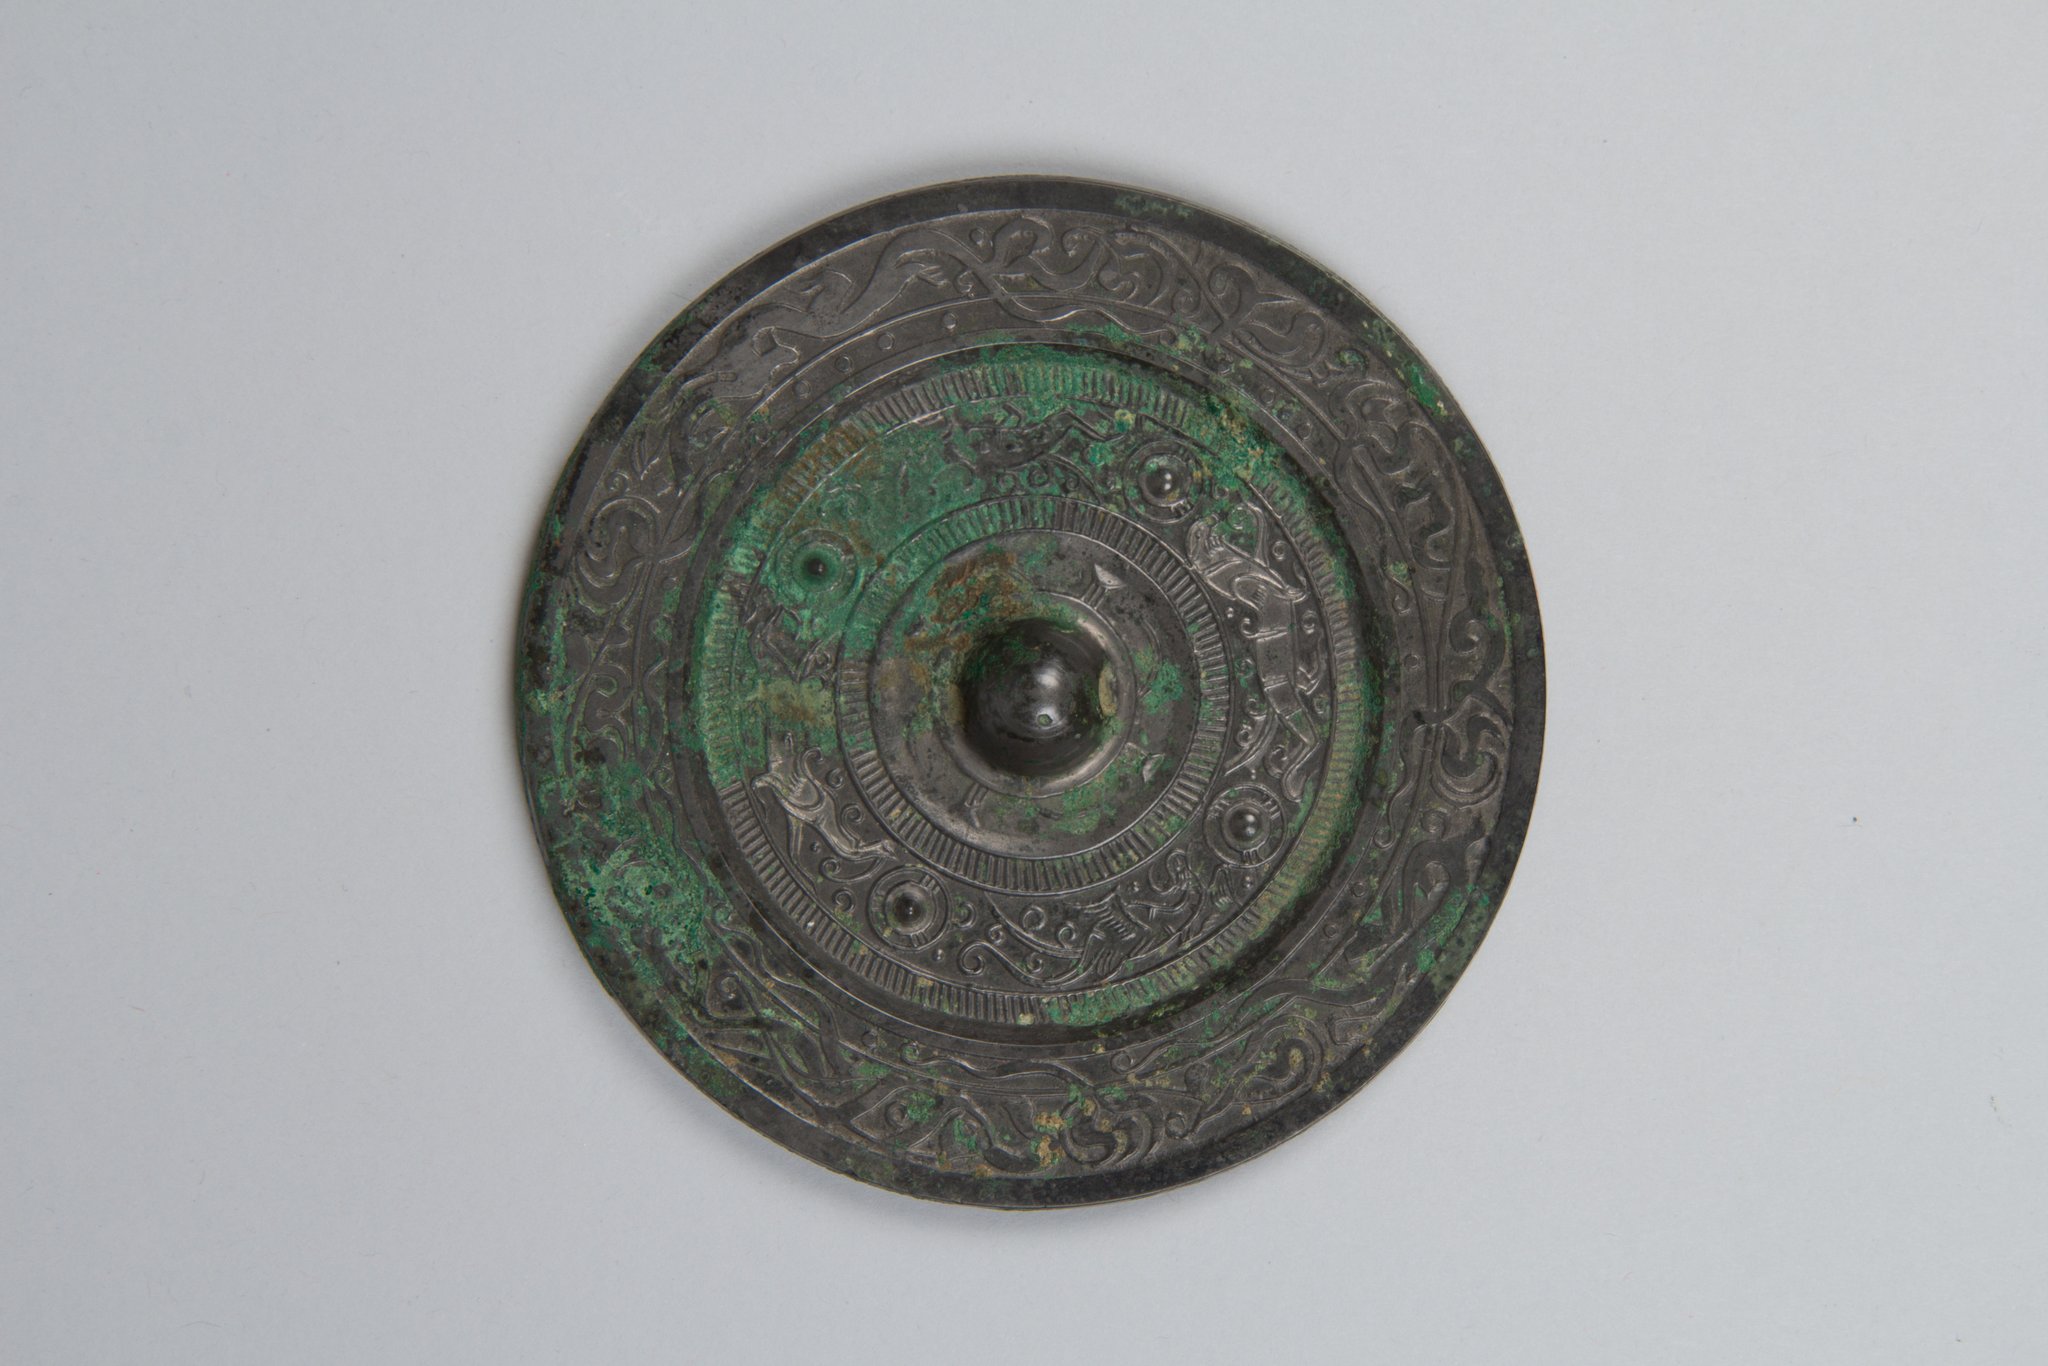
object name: mirror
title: Mirror with animals of the four directions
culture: chinese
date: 67-1 BCE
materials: bronze, silver